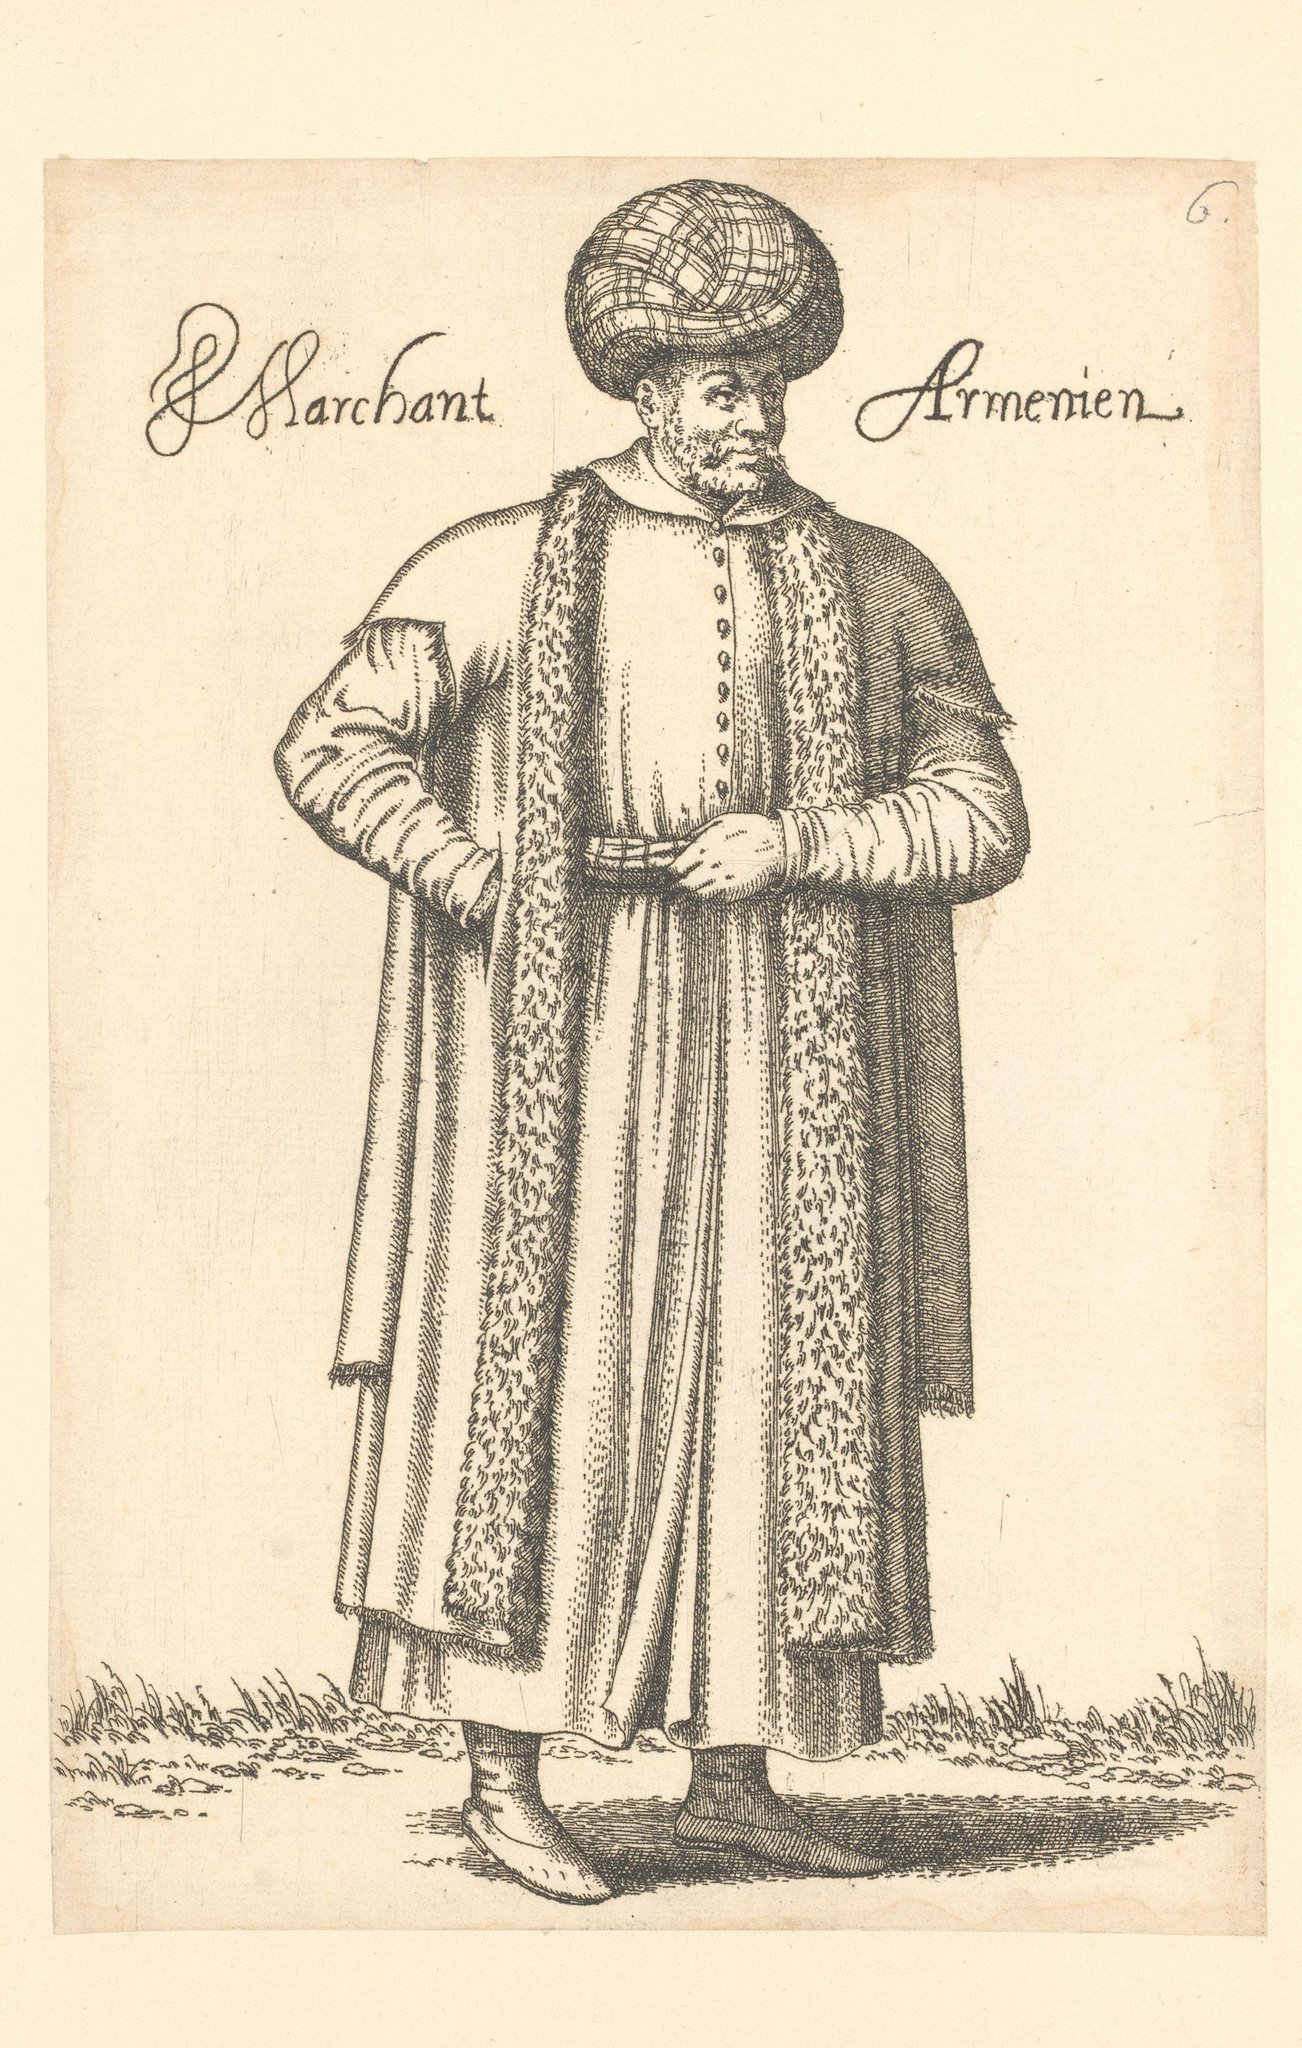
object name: print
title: Marchant Armenien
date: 1555-1568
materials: paper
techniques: etching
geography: lyon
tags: asiatic races and peoples (+ costume), asiatic races and peoples (with name), merchant, salesman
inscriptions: collector's mark: Lugt 2760, collector's mark: Lugt 2228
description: Prent uit: Nicolay, Nicolas de. Les quatre premiers livres des navigations et pérégrinations orientales, de N. de Nicolay, (...) Avec les figures au naturel tant d'hommes que de femmes selon la diversité des nations, & de leur port, maintien & habitz. Lyon: Guillaume (I) Rouille, 1568.